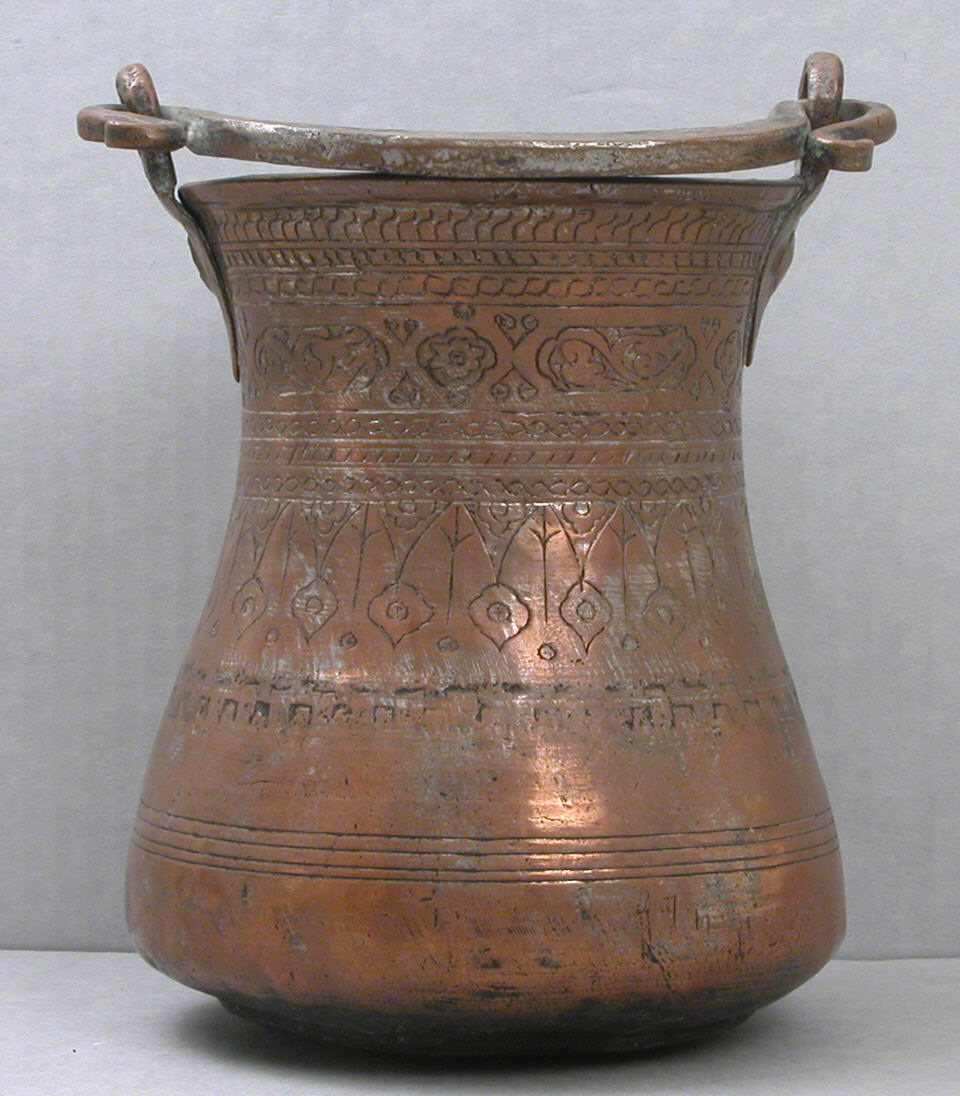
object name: bucket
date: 1701-1900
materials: copper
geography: turkey